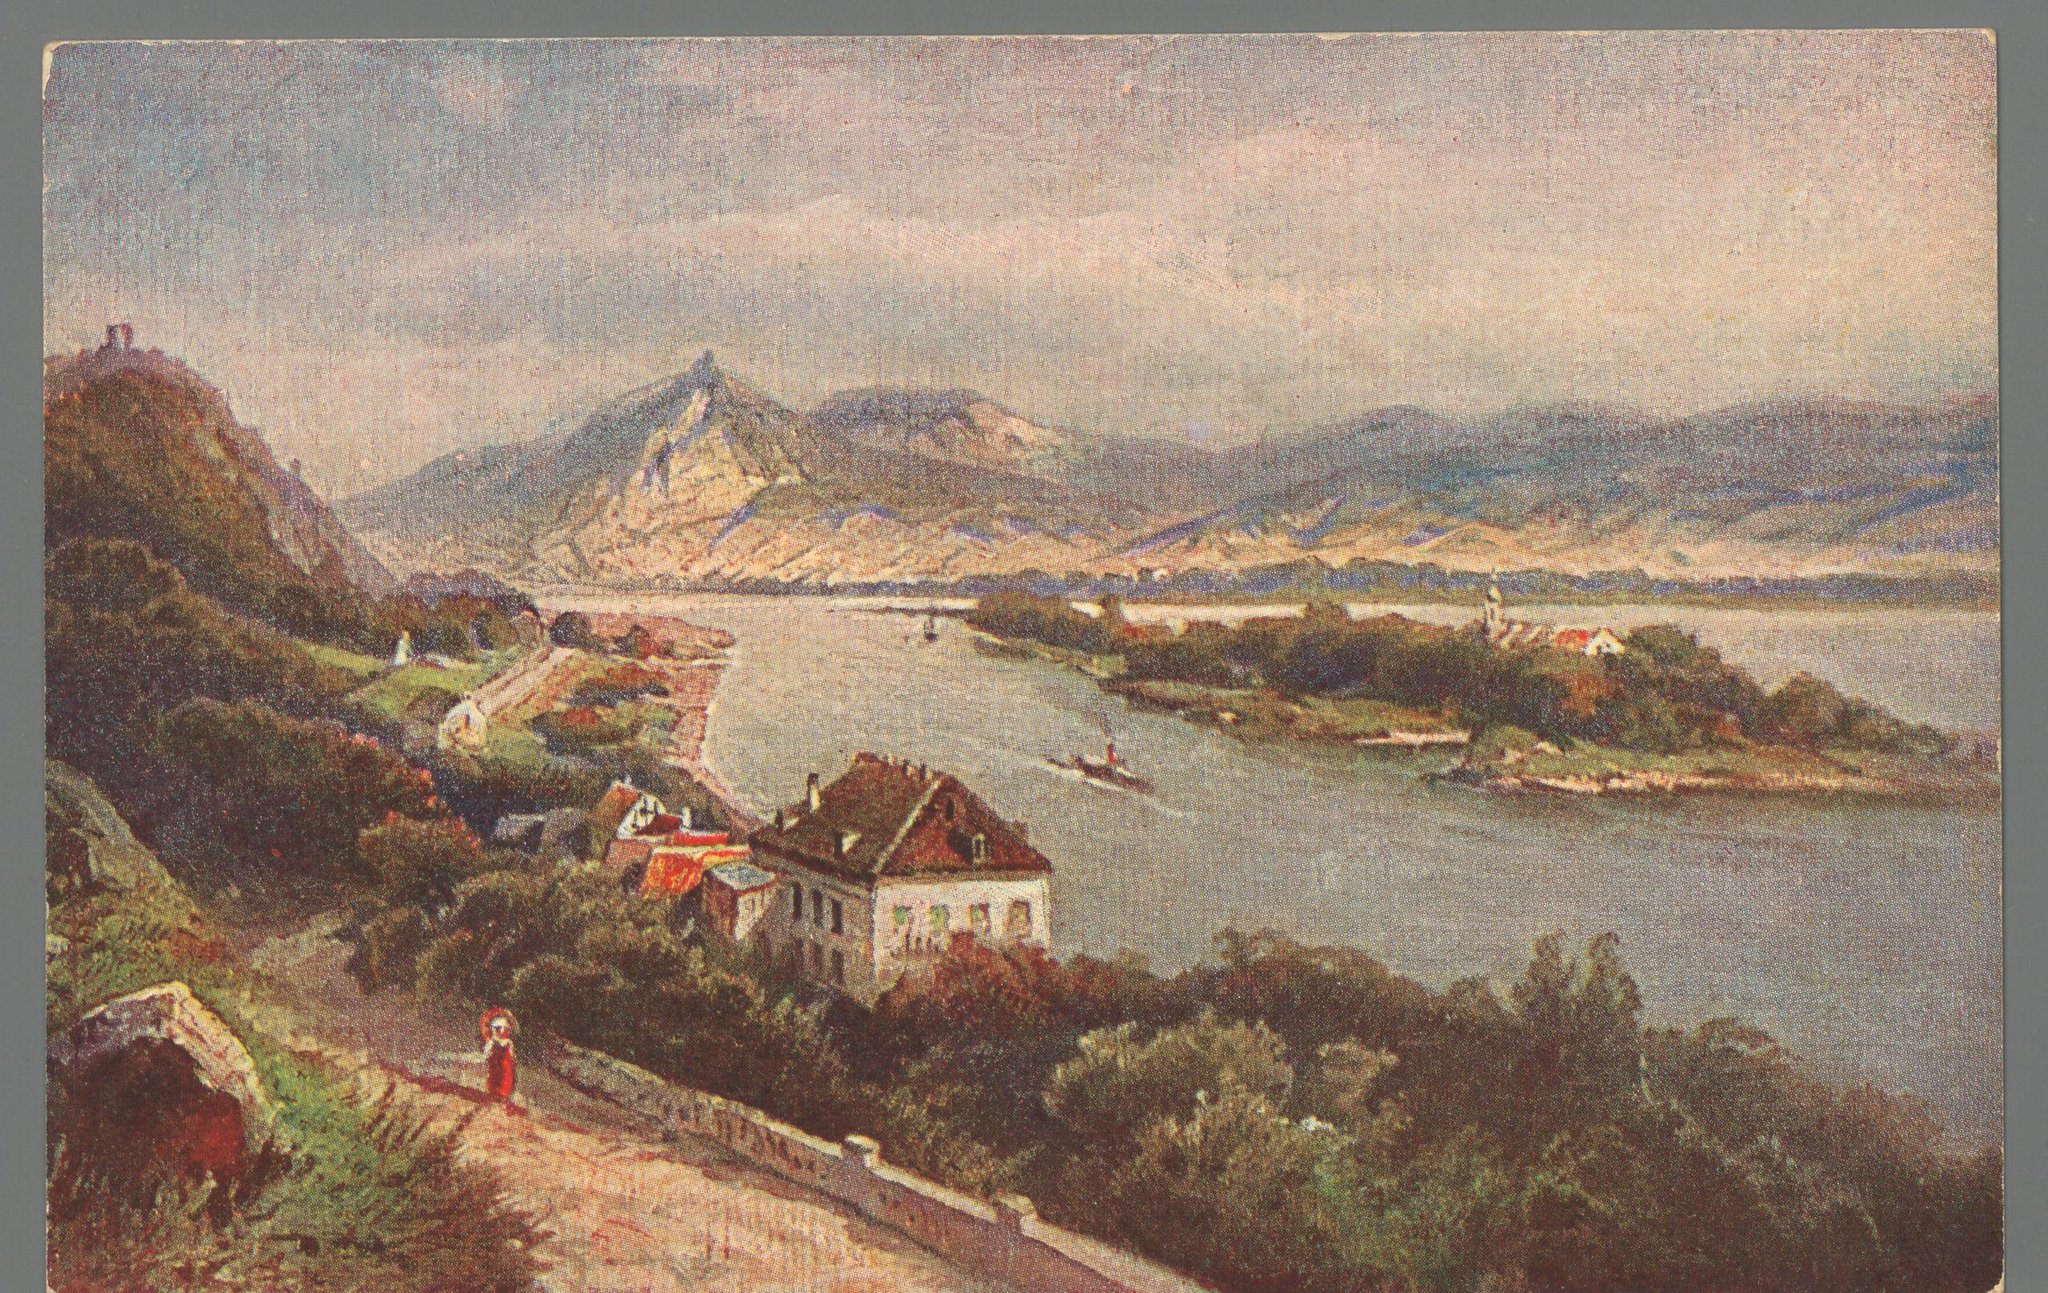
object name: reproduction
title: Rolandseck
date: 1905-1930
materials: cardboard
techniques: color autotype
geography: cologne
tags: city-view, and landscape with man-made constructions, river